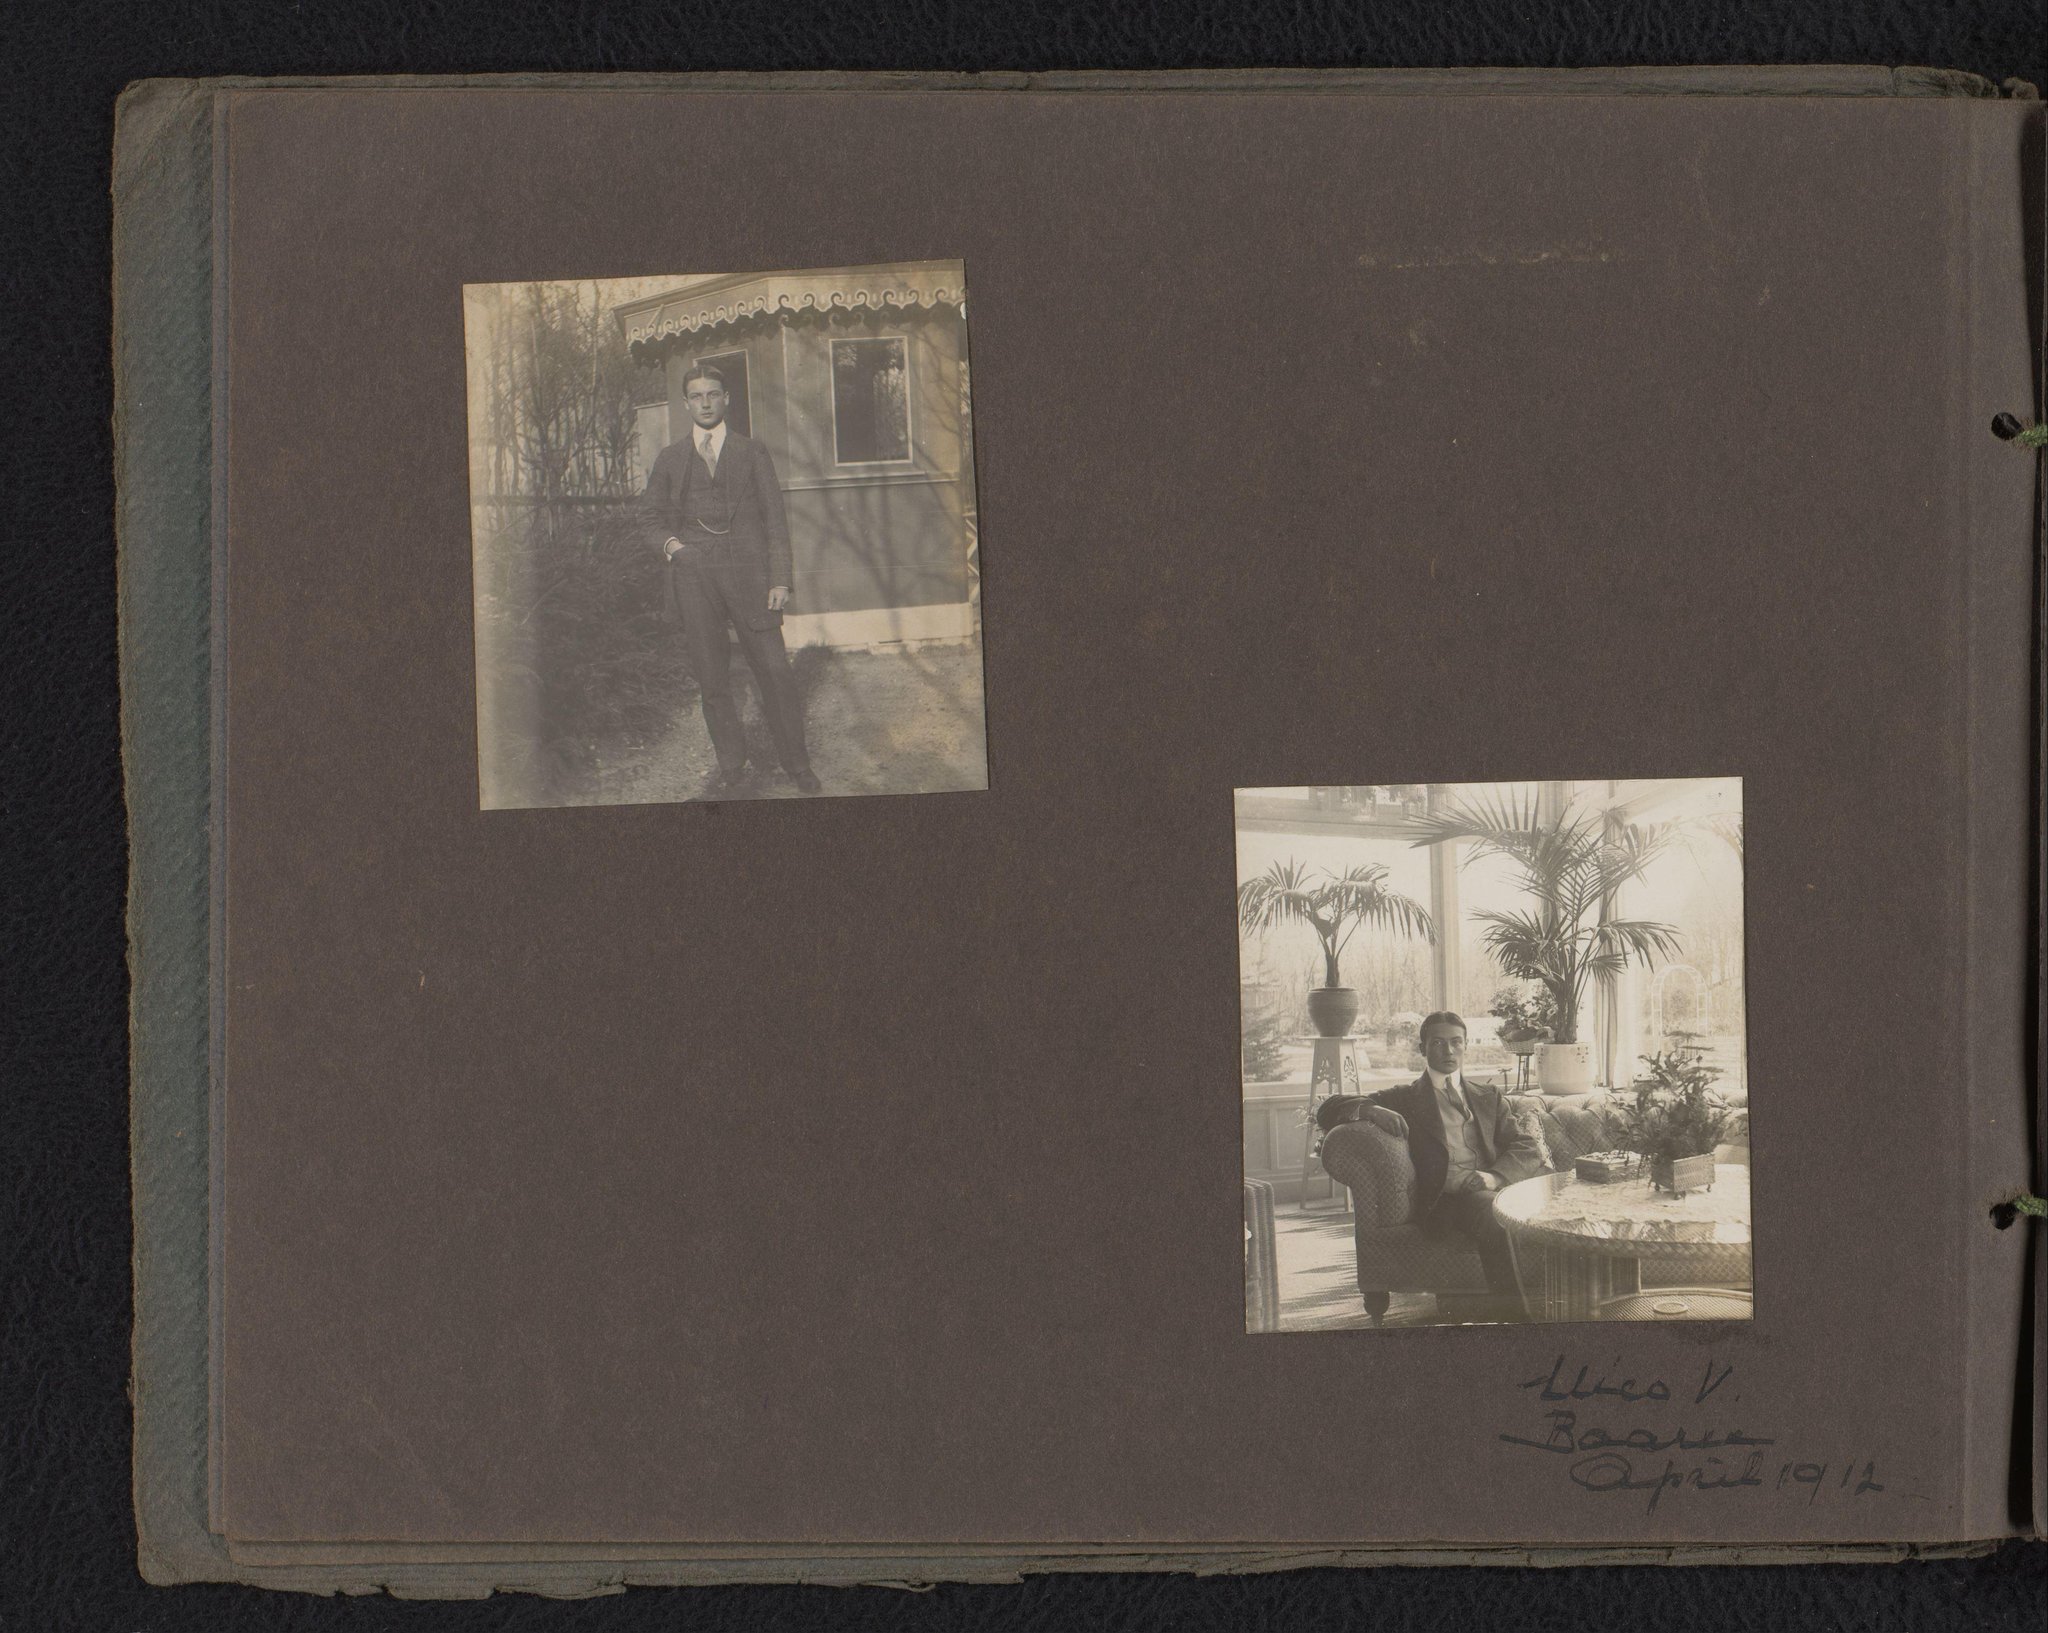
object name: photograph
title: Nico van Baarn in en buiten een woning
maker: carolina frederika onnen (lien/loen)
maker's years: 1896-1983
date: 1904-1912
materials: paper, cardboard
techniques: gelatin silver print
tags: historical persons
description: Deze foto's zijn onderdeel van een album.